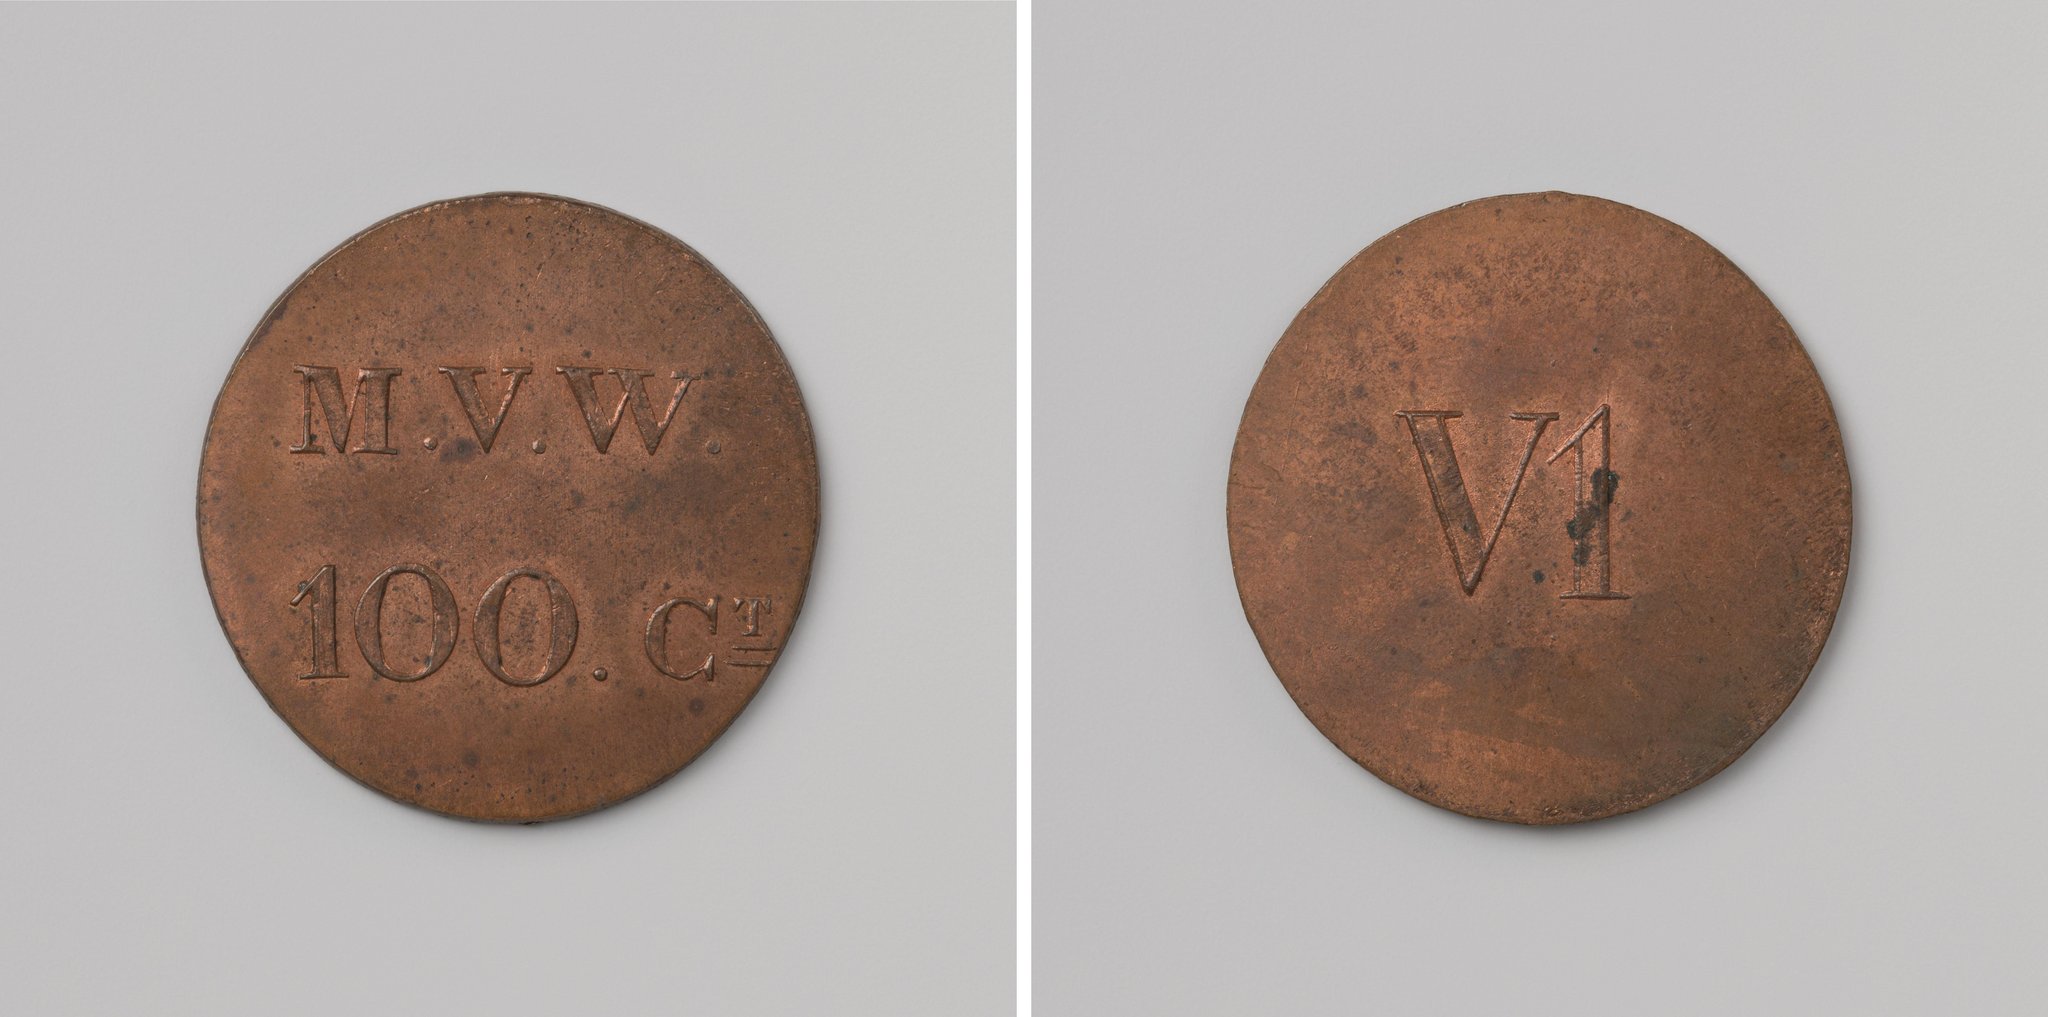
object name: huismunt prison money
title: Eerste gesticht van de strafkolonie Veenhuizen, huismunt geslagen op last van de Maatschappij van Weldadigheid ter waarde van 1 gulden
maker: Anonymous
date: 1818-1859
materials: copper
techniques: striking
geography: netherlands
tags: maatschappij van weldadigheid, veenhuizen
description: Voorzijde: opschrift boven waardeaanduiding. Keerzijde: opschrift V 1